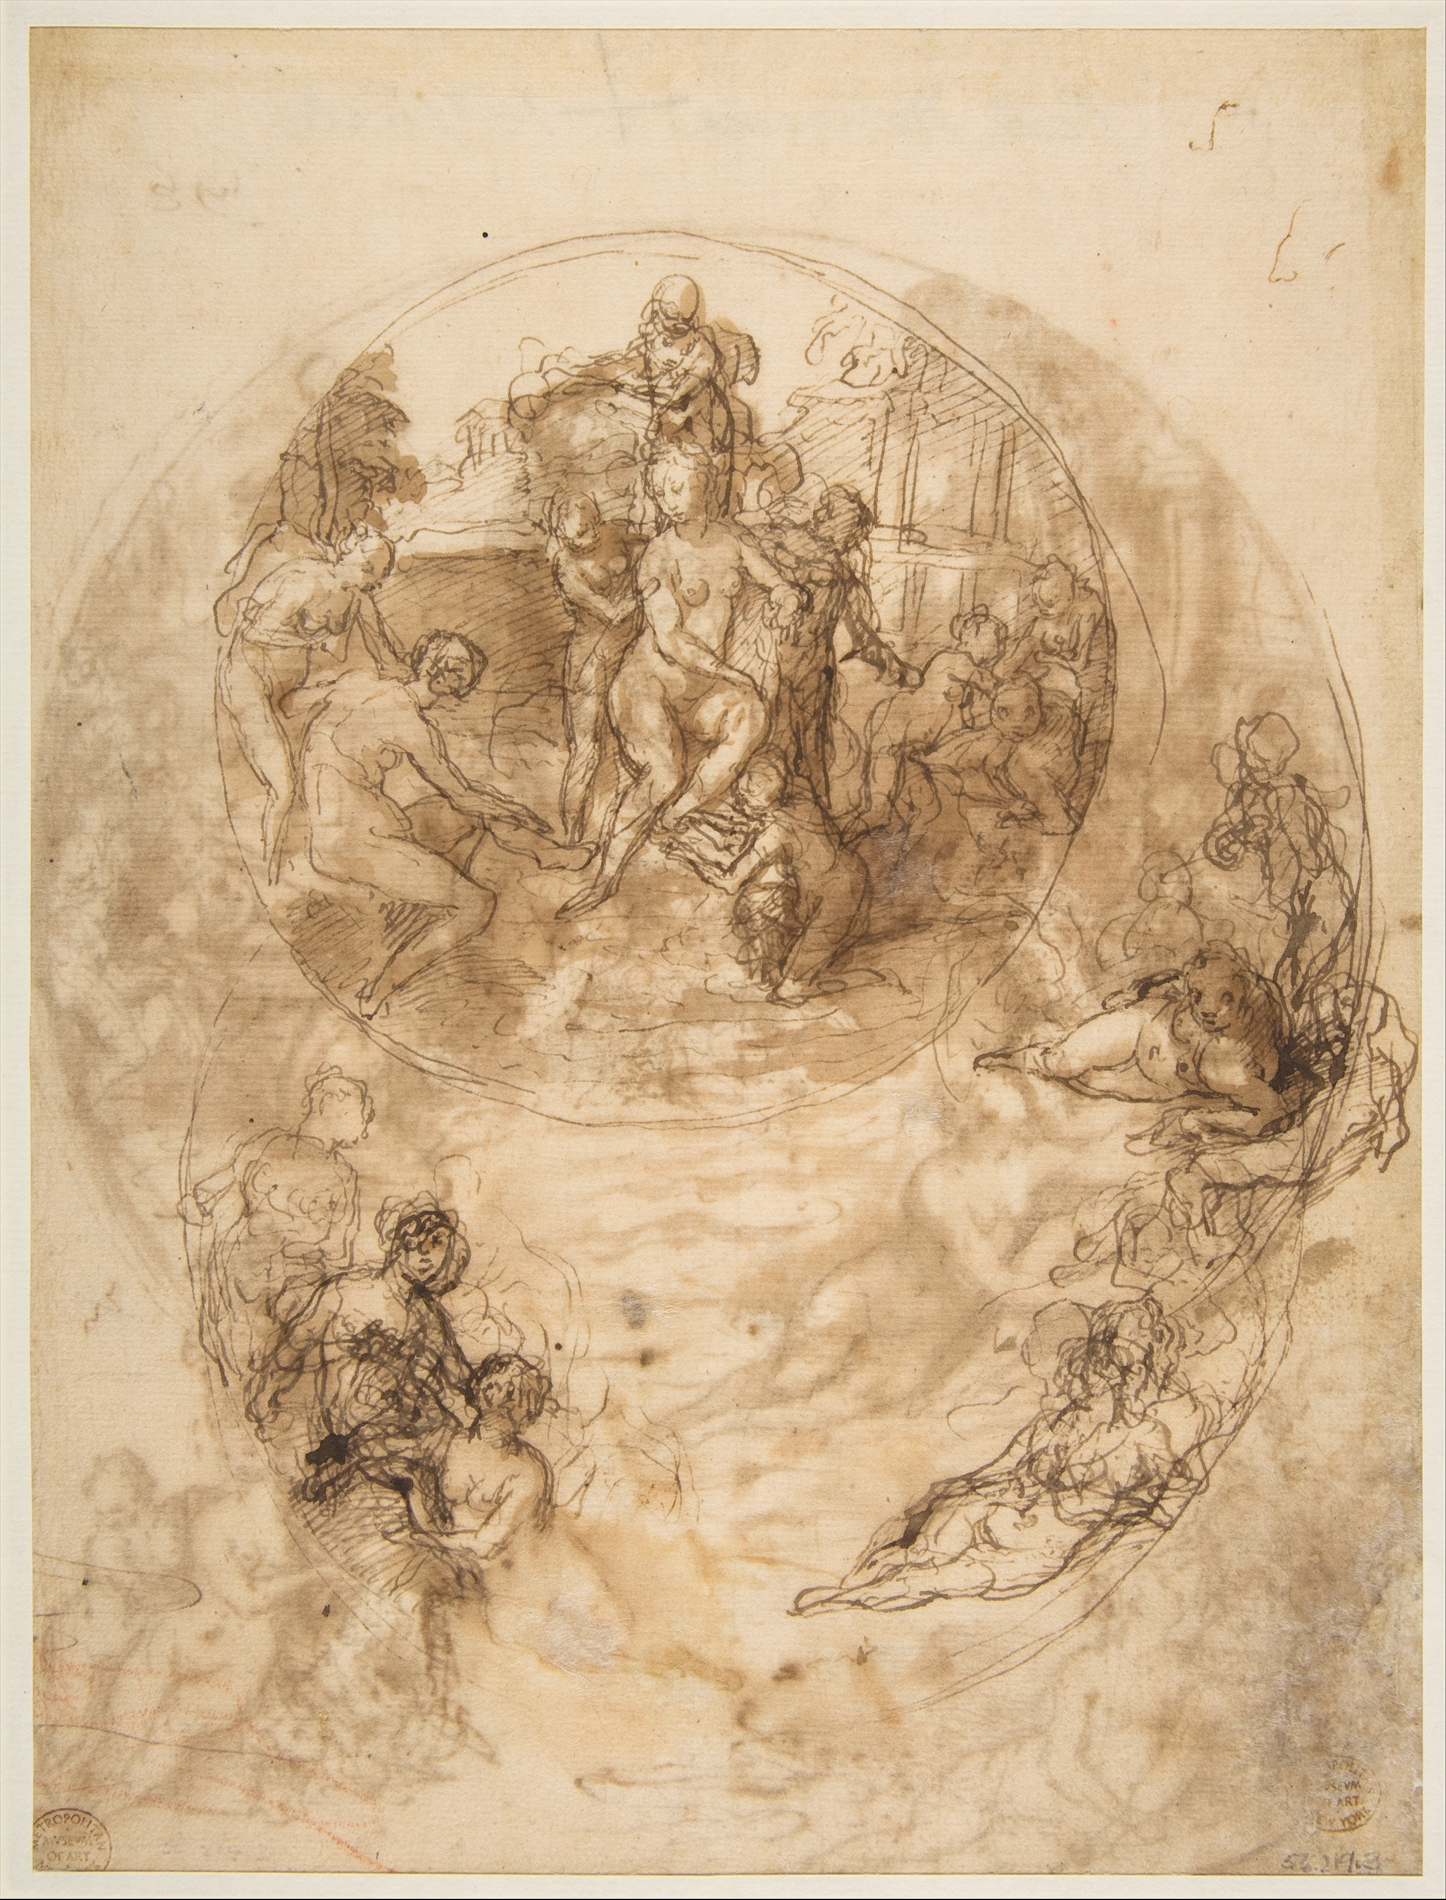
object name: drawing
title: Studies for a Circular Composition of Diana and Her Nymphs Bathing (recto); Studies for the Same Composition (verso)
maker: taddeo zuccaro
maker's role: artist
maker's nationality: italian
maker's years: 1529-1566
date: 1529-1566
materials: ink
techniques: brush, pen, wash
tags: nymphs,diana,bathing